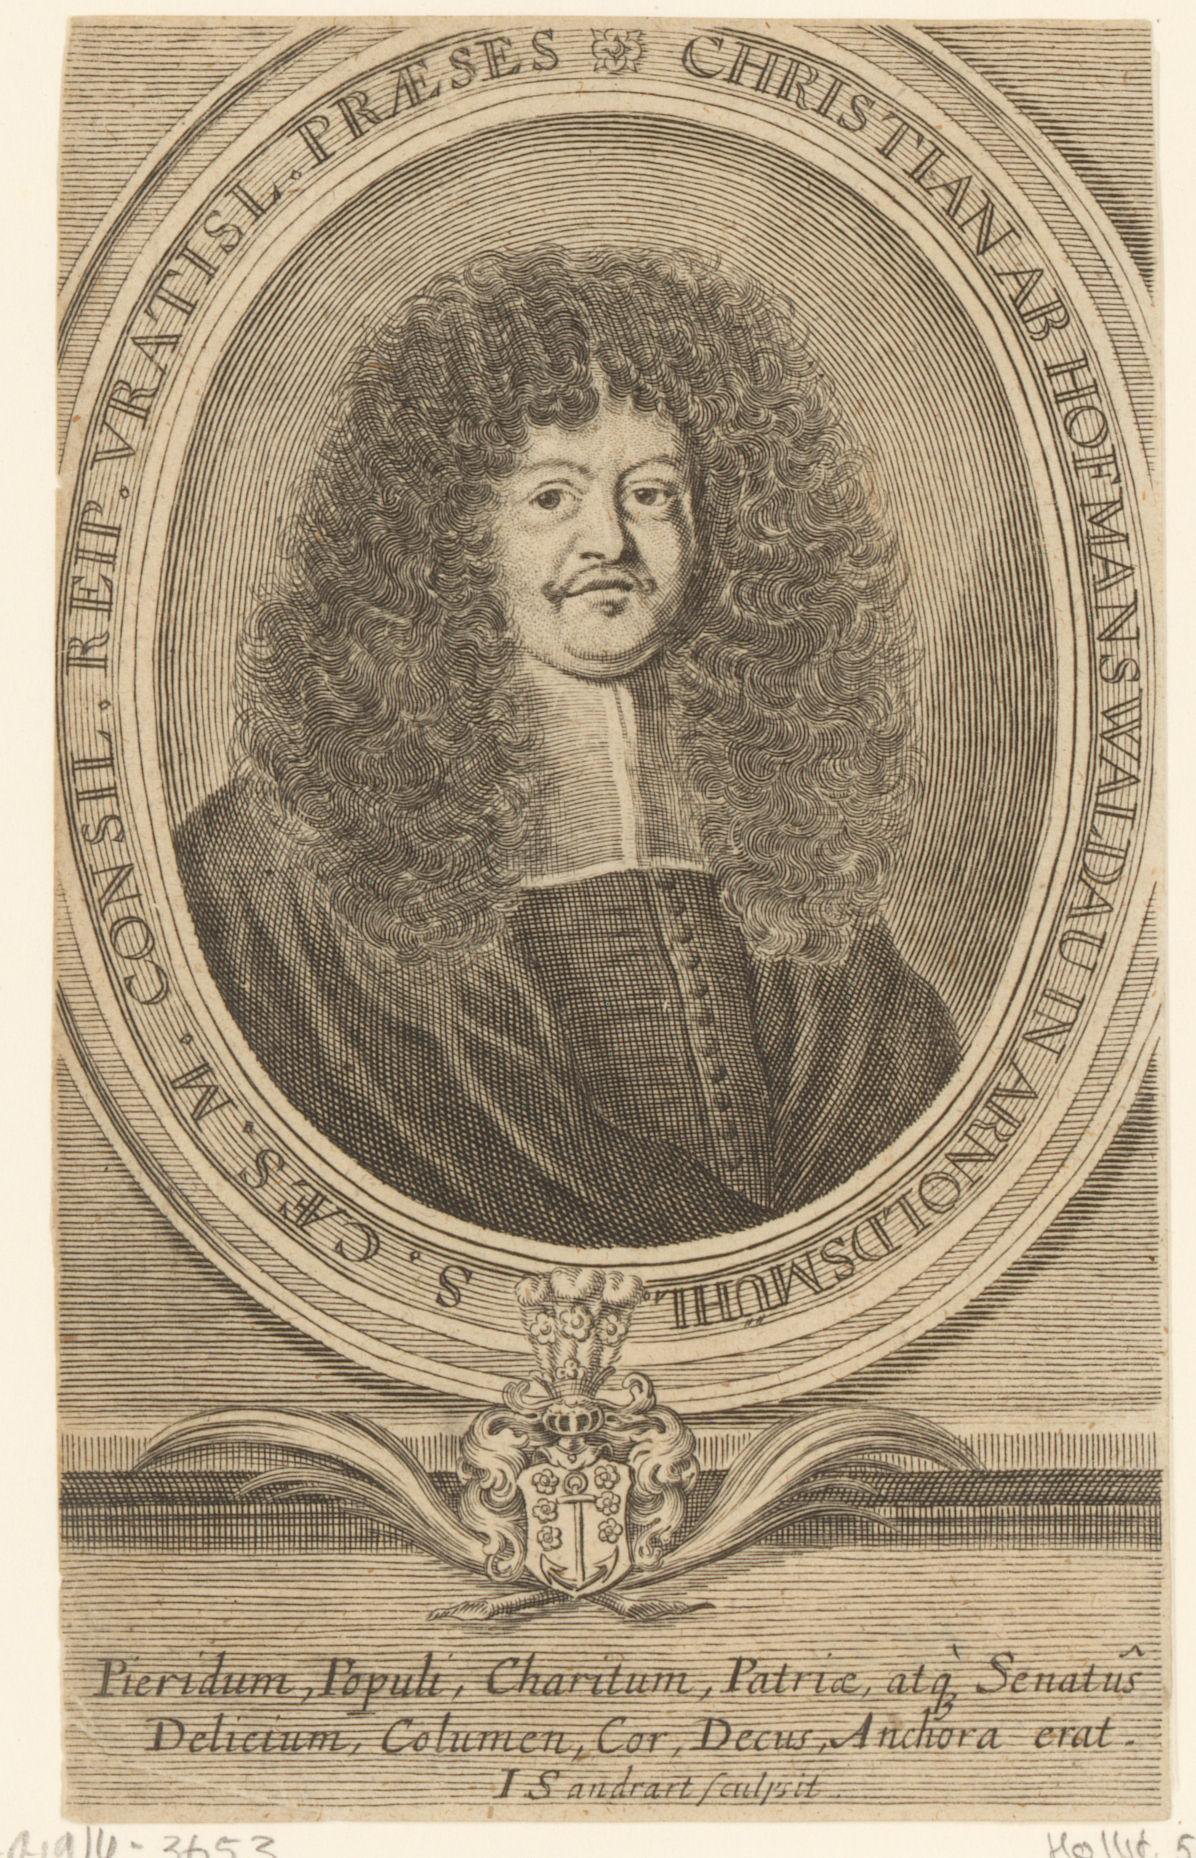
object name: print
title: Portret van Christian Hofmann von Hofmannswaldau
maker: jakob von sandrart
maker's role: print maker, publisher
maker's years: 1630-1708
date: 1679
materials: paper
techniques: engraving, etching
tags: historical persons, writer, poet, author, armorial bearing, heraldry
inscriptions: collector's mark: Lugt 2228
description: Prent ook gebruikt in: Lohenstein, D.C. von. Lob-Rede. Wroclaw: Esaias Fellgiebel, 1679.